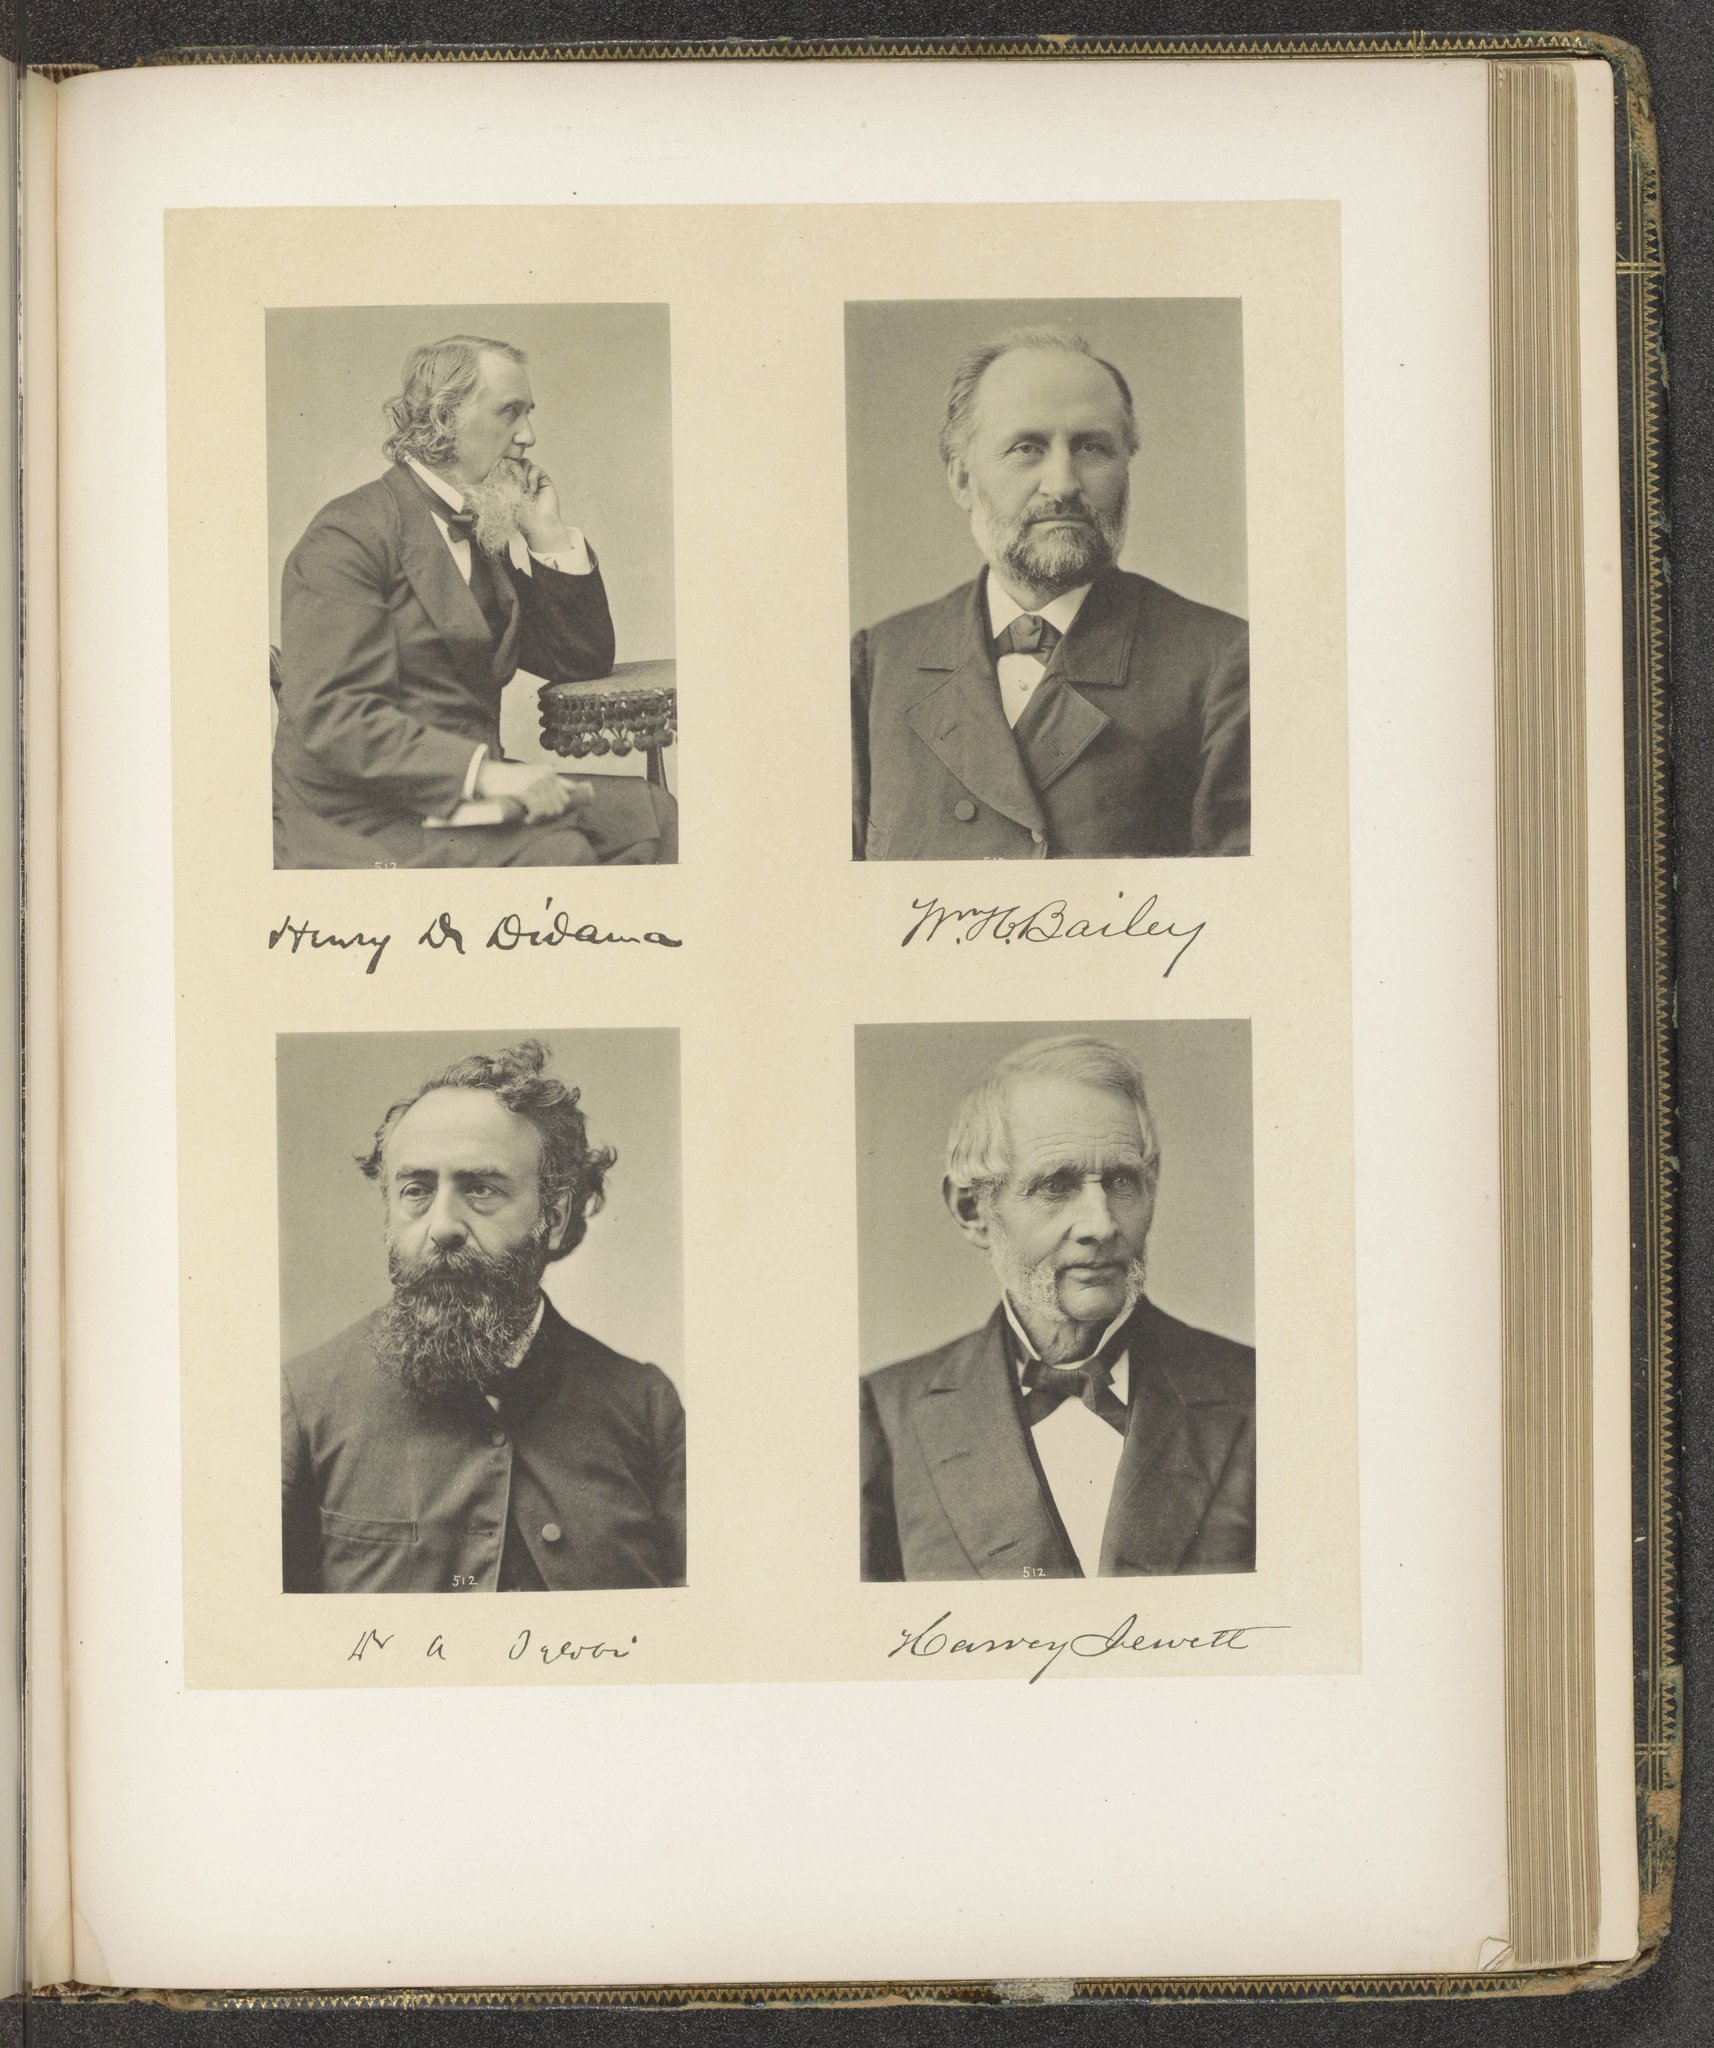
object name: page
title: Portretten van vier leden van de medische sociëteit van de staat New York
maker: Anonymous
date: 1872-1882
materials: paper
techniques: photograph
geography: united states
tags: historical persons (portraits and scenes from the life) (+ head (and shoulders) (portrait))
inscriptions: number: ‘512’, annotation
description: Linksboven Henry D. Didama, rechtsboven William H. Bailey, linksonder Abraham Jacobi, rechtsonder Harvey Jewett.